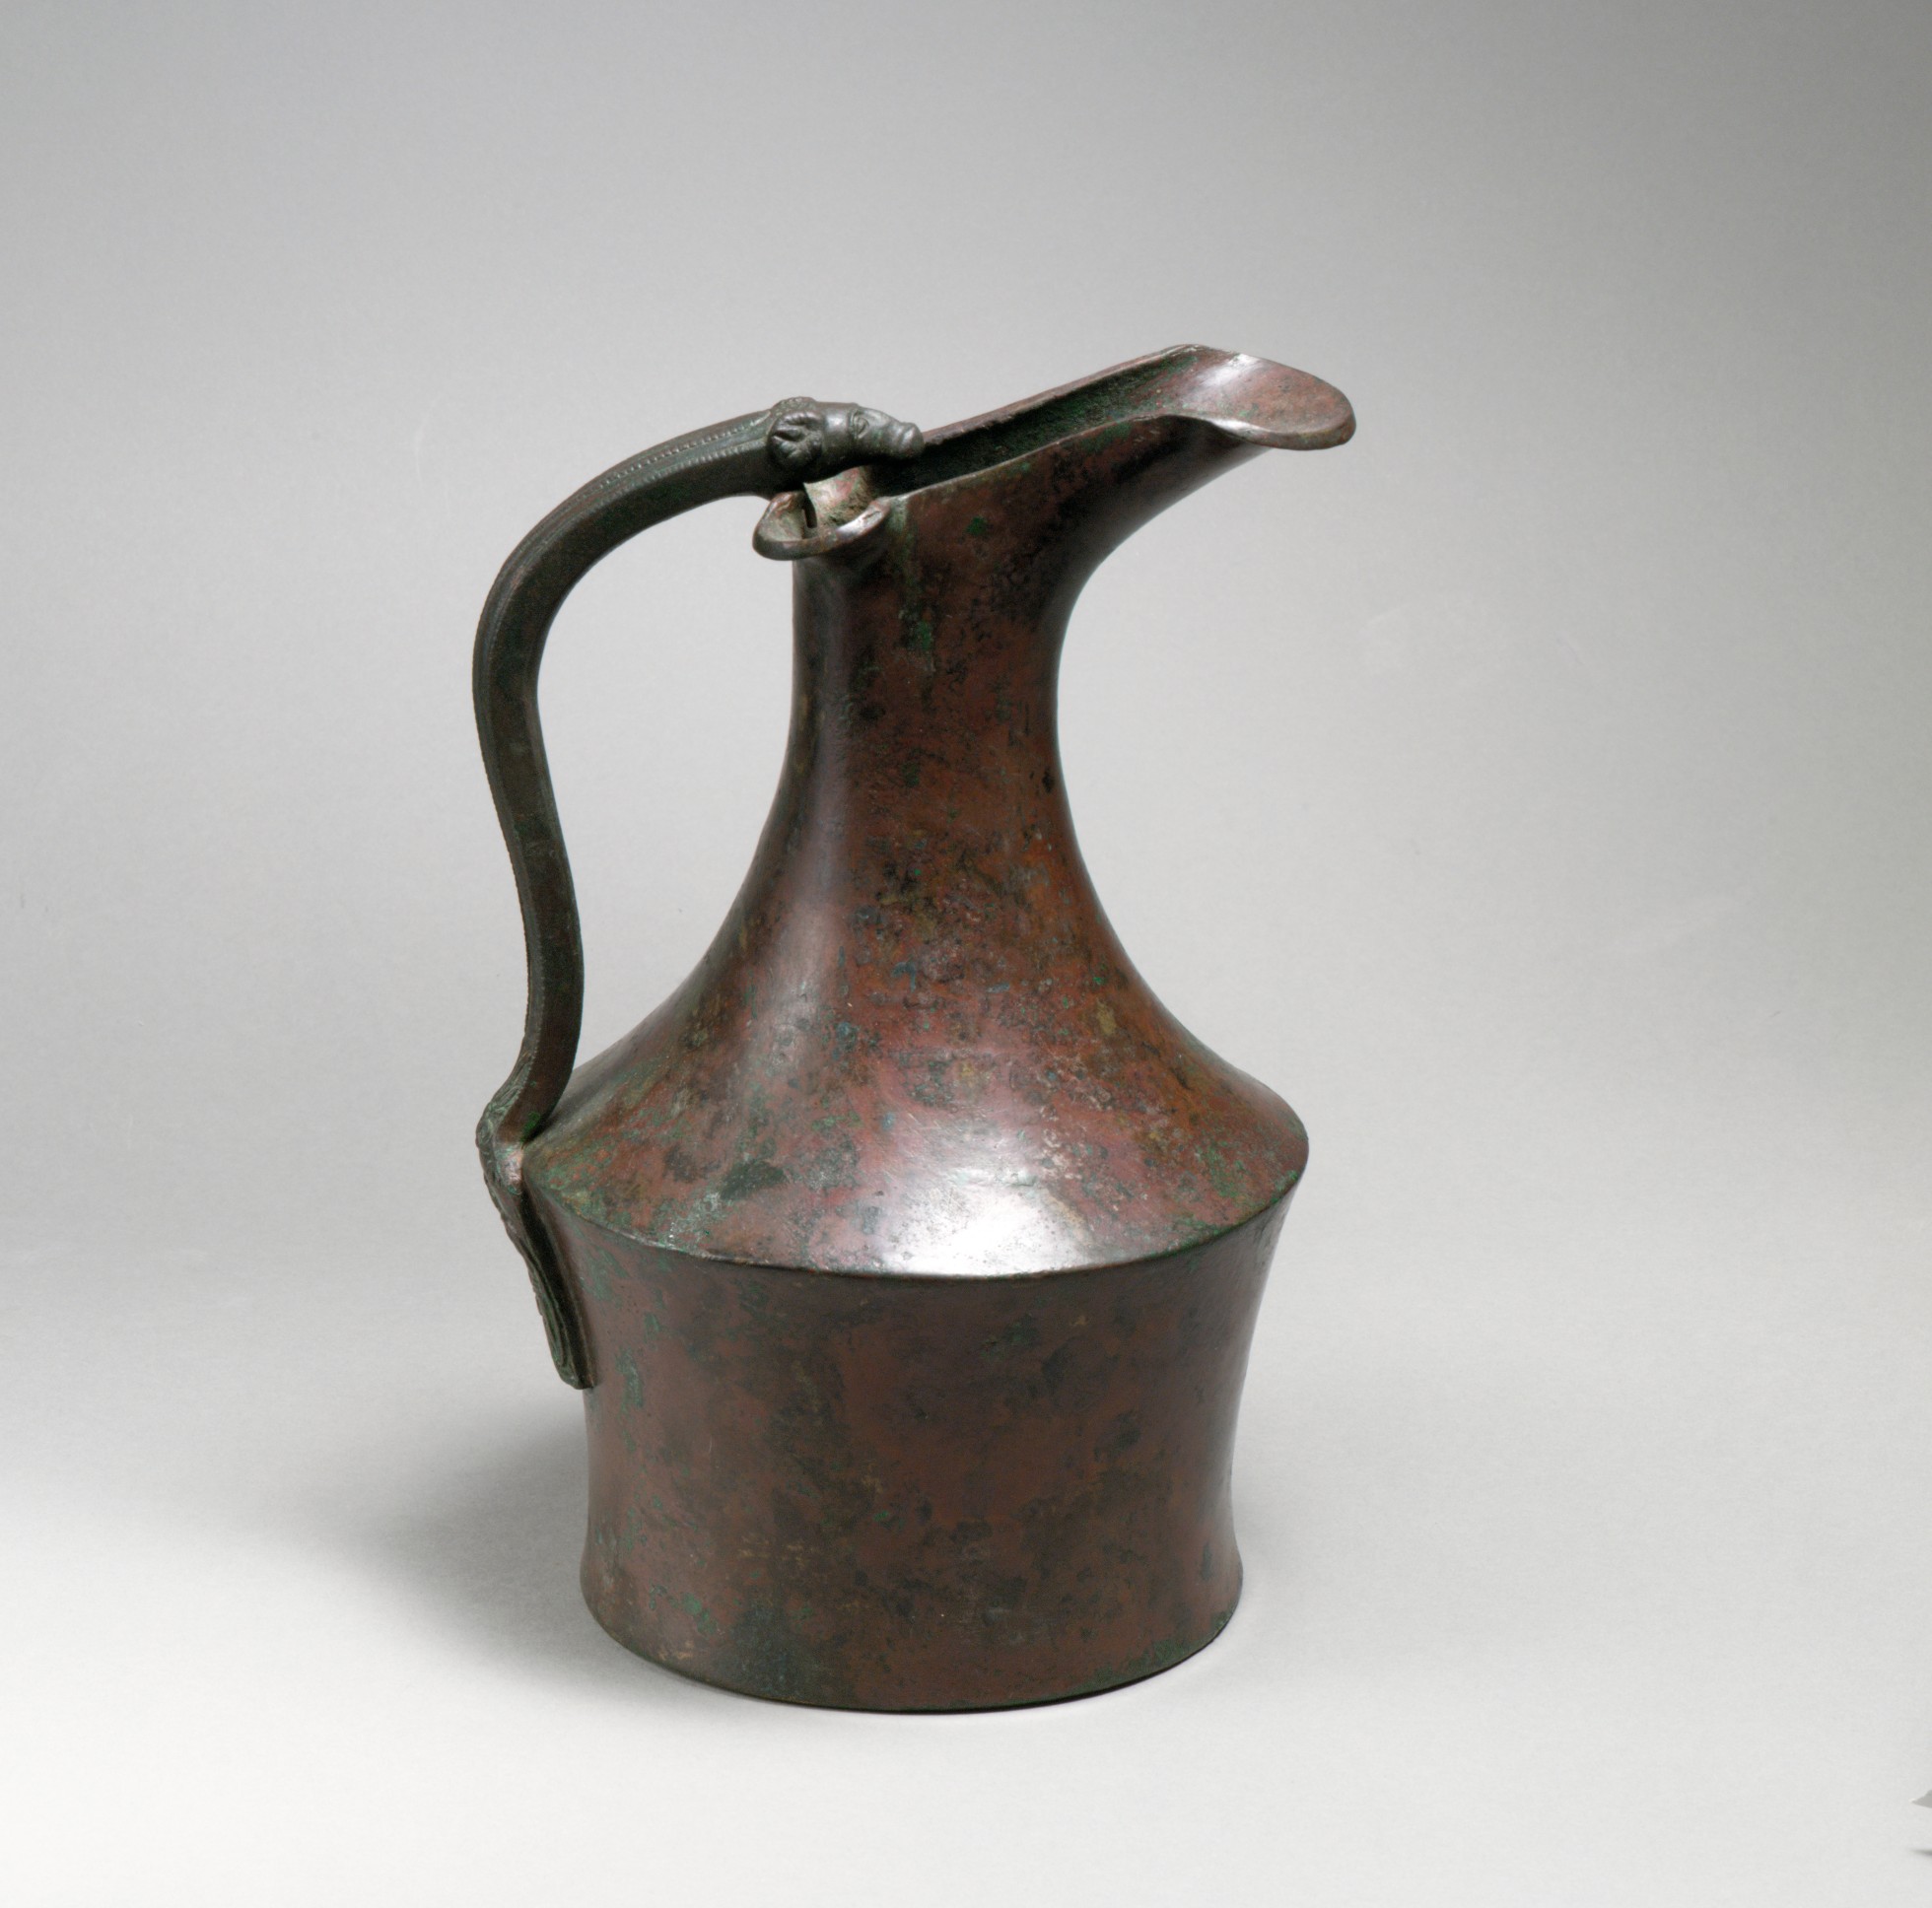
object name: jug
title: Bronze oinochoe (jug) and handle attachment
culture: etruscan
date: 425-400 BCE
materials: bronze